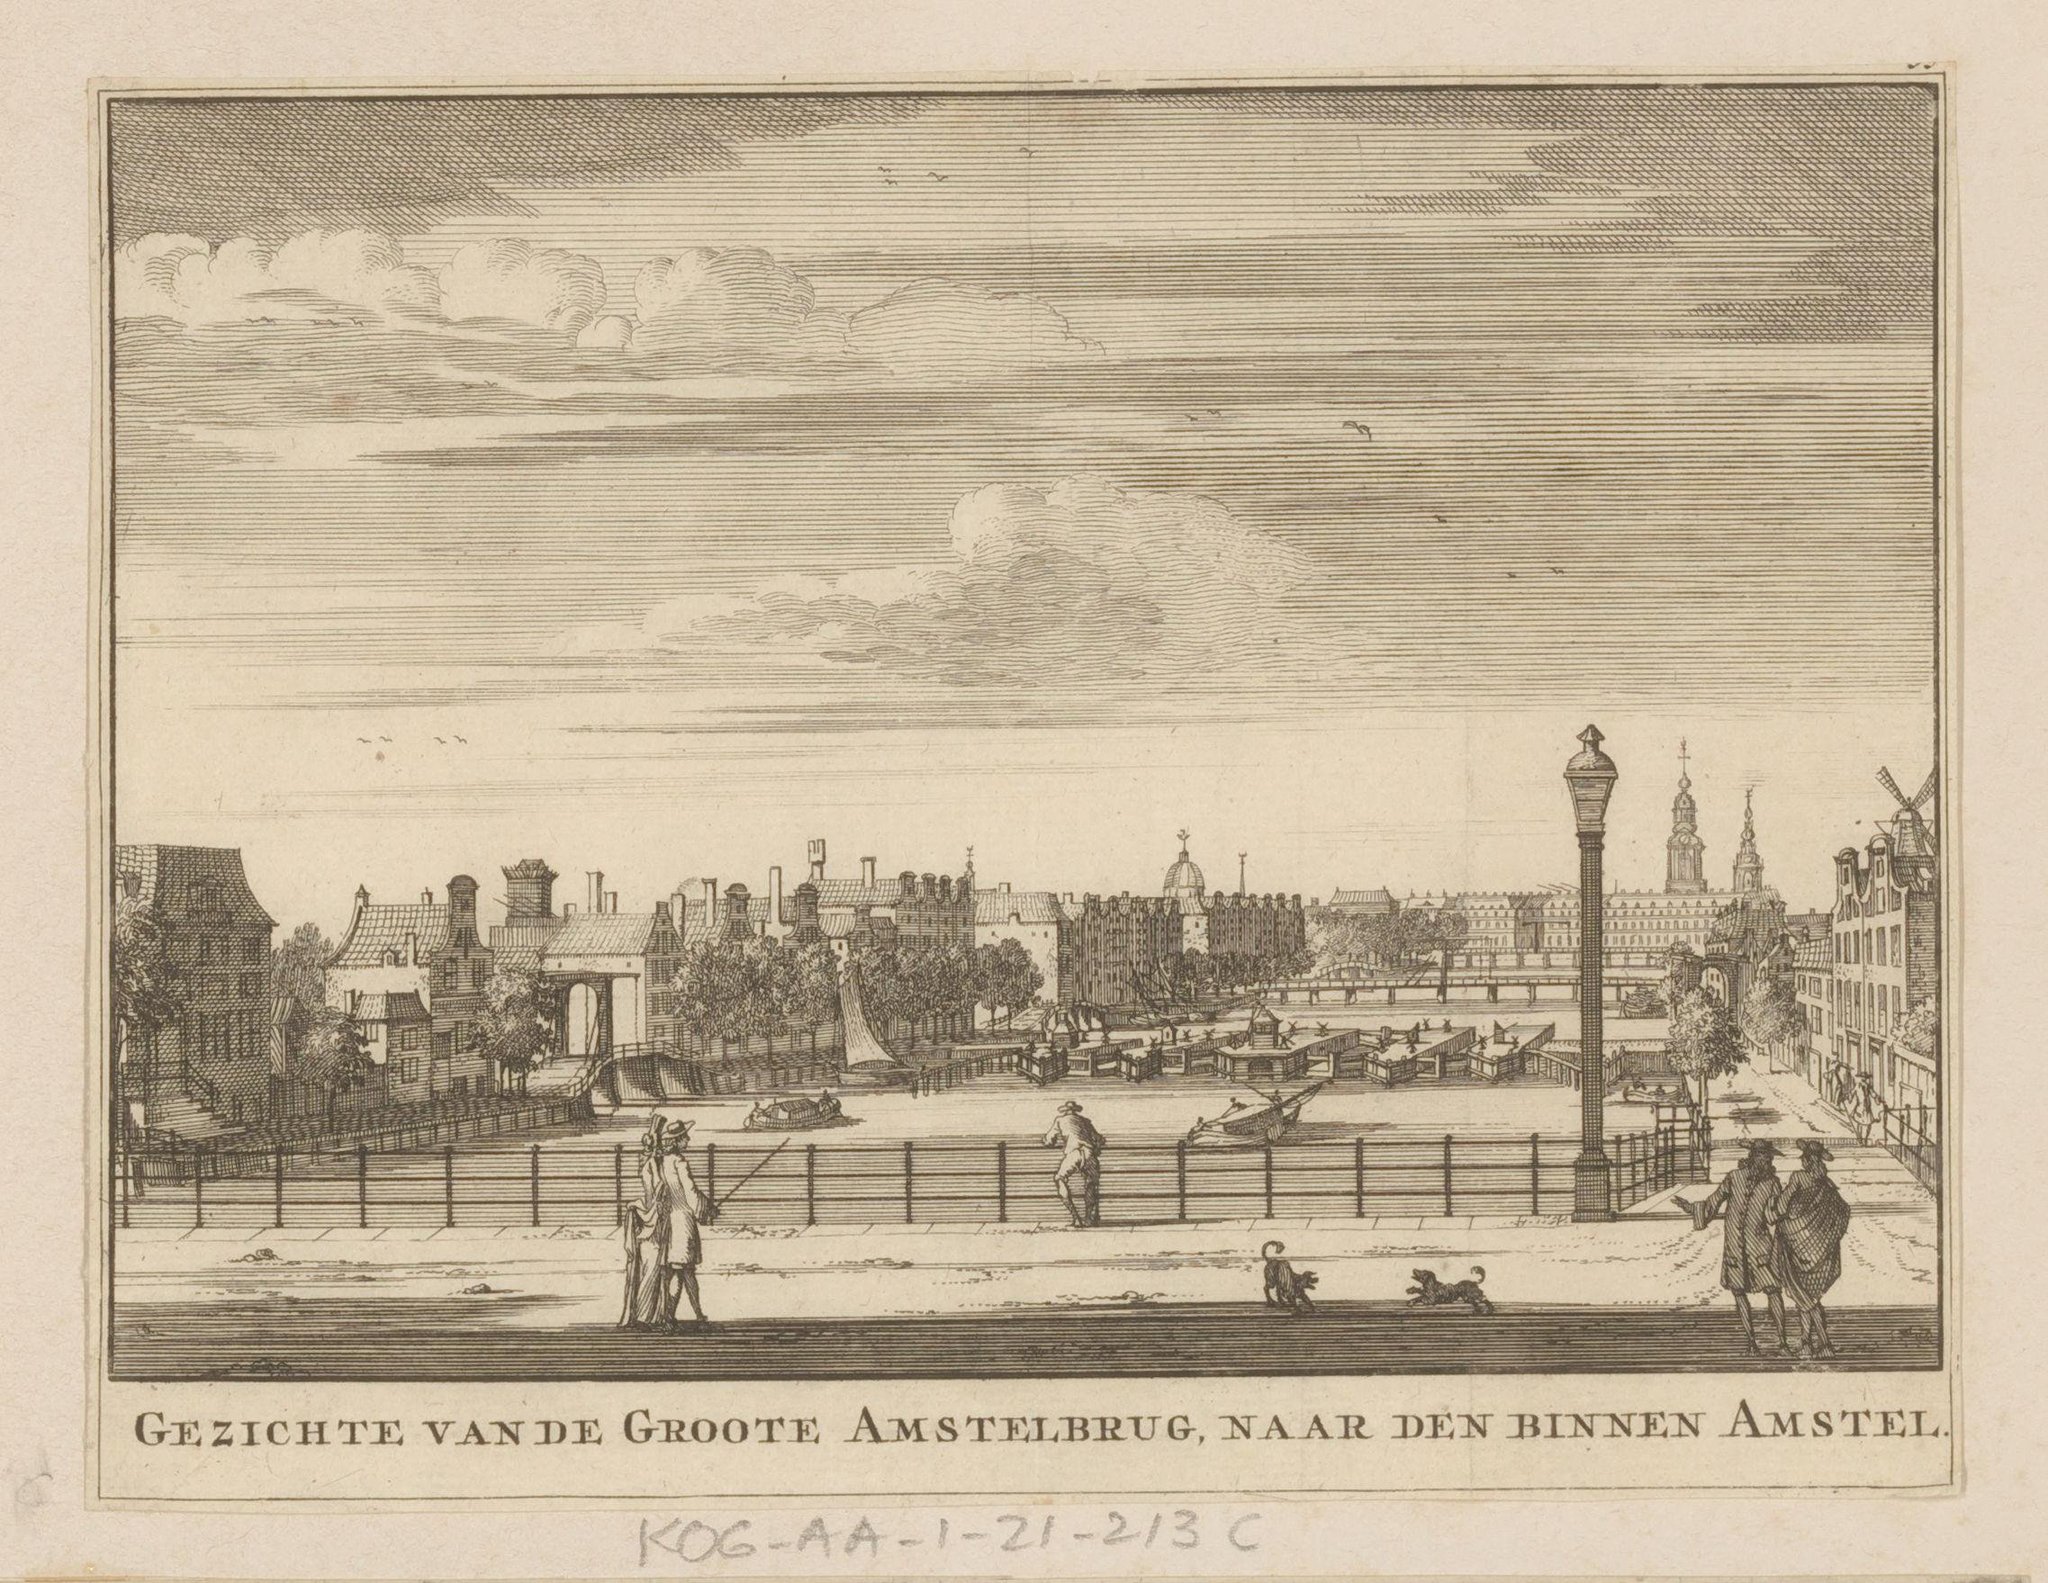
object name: print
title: Gezichte van de Groote Amstelbrug, naar den Binnen Amstel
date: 1713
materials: paper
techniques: etching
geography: amsterdam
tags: sluice, weir, city-view, and landscape with man-made constructions, canals, waters (in city), bridge in city across river, canal, etc.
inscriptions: collector's mark: Lugt 1641b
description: Prent waarschijnlijk uit: Hoorn, Nicolaas ten. Wegwyzer door Amsterdam zynde eene beknopte verhandeling van desselfs eerste opkomst, vergrootingen, en teegenwoordigen staat (...). Amsterdam: Nicolaas ten Hoorn, 1713.